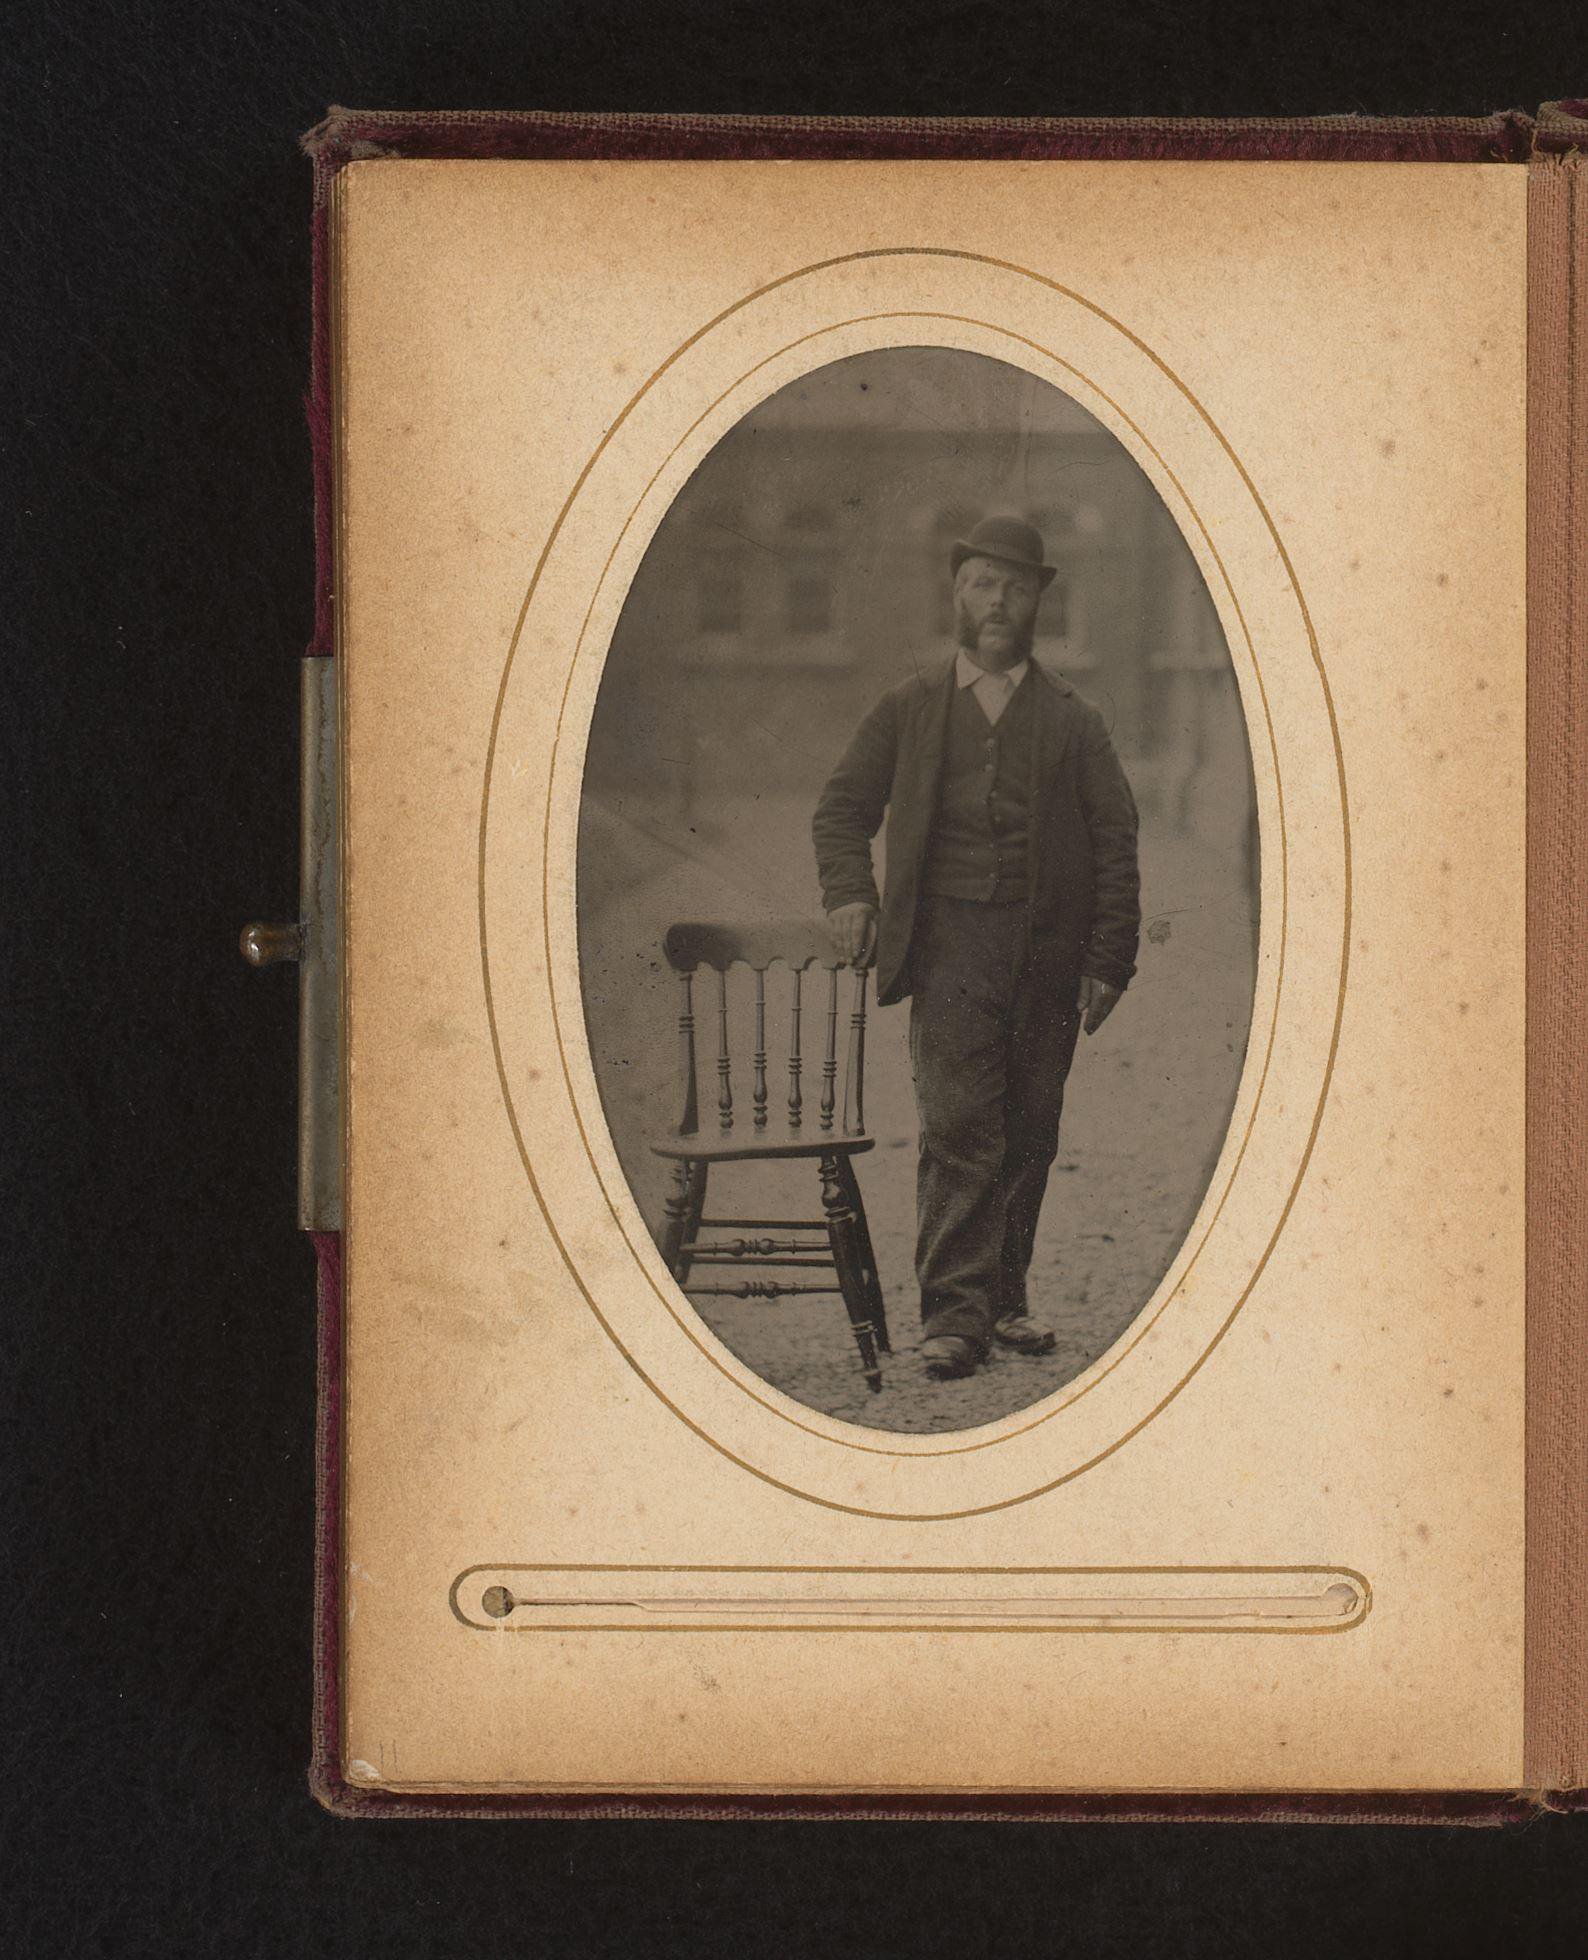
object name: album leaf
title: Portret van een man met baard en een hoed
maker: Anonymous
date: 1870-1882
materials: iron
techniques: ferrotyping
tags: head-gear: bowler hat, adult man, historical persons, beard